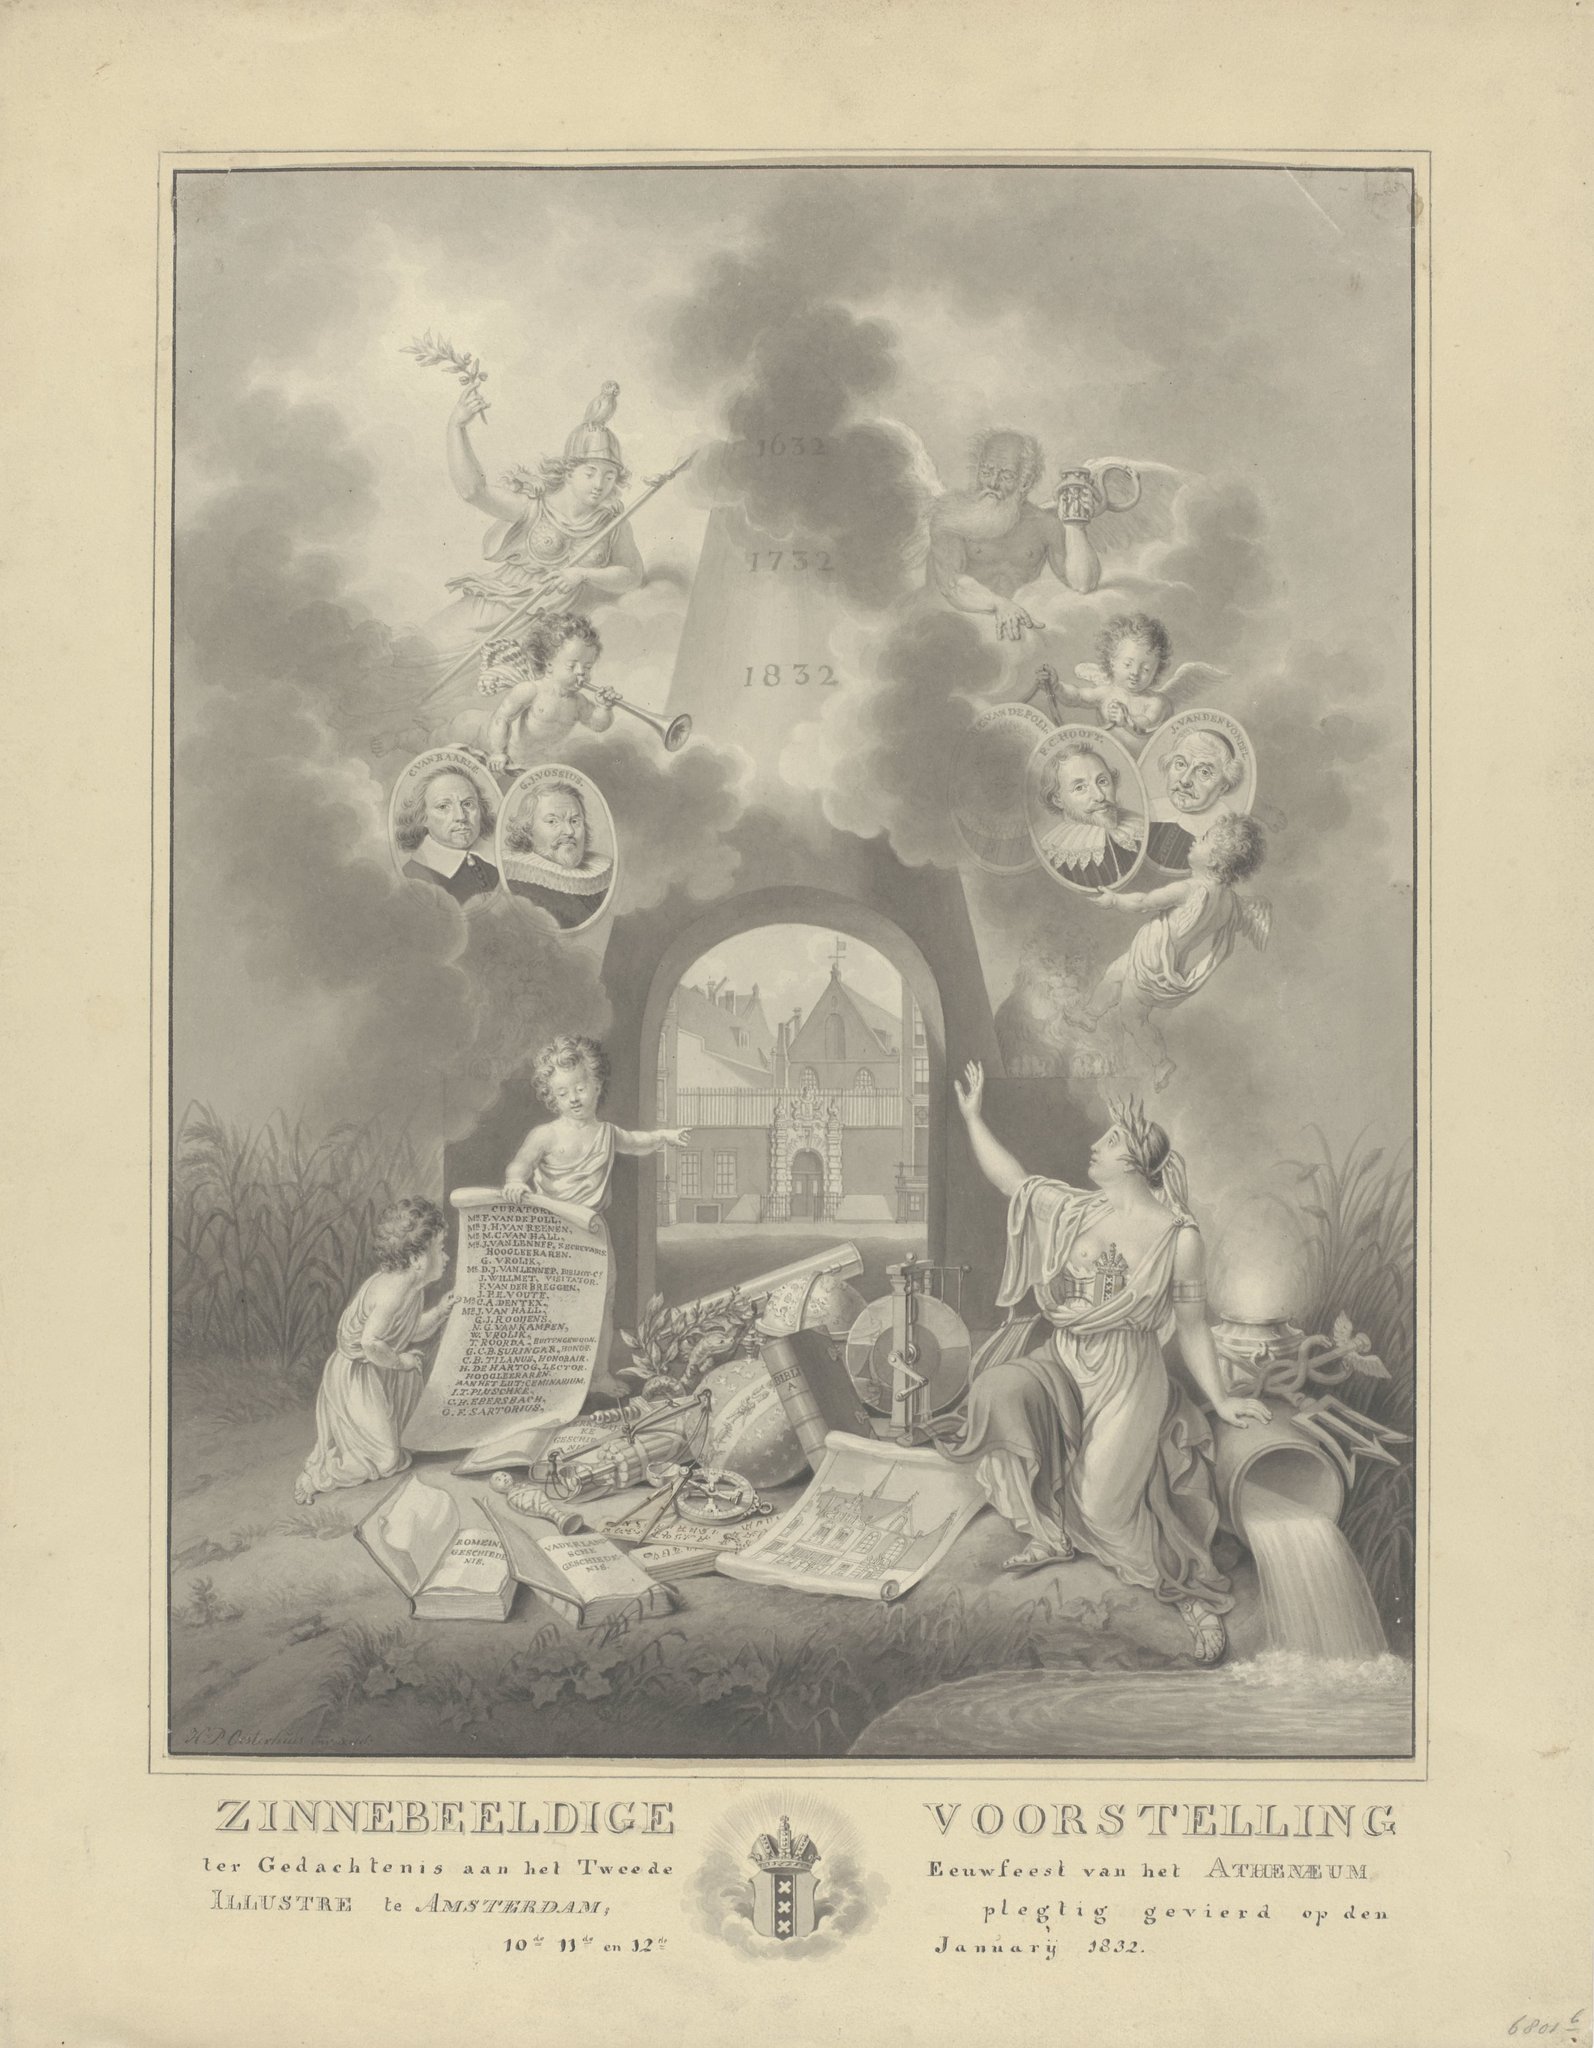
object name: drawing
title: Allegorie op het tweede eeuwfeest van het Athenaeum Illustre te Amsterdam, 1832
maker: dirk sluyter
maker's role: print maker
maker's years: 1790-1852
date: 1832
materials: paper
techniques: brush, pen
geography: amsterdam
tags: antwerp, amsterdam, caspar van baerle, gerardus joannes vossius, pieter corneliszoon hooft, cologne, joost van den vondel, personification of a city, town-patron(ess), father time, man with wings and scythe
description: Allegorie op het tweede eeuwfeest (1632-1832) van het Athenaeum Illustre te Amsterdam, gevierd 10-12 januari 1832. Naald met opening waardoor een gezicht op de poort naar de Agnietenkapel aan de Oudezijds Voorburgwal te Amsterdam waar Athenaeum Illustre is gevestigd. Rechts de stedenmaagd van Amsterdam, links twee geniussen met een lijst van de namen van de curatoren en professoren. Op de grond boeken en wetenschappelijke instrumenten. In de wolken Minerva en Vader Tijd met medaillons met portretten van Caspar van Baerle, H.G. van de Poll, Vossius, P.C. Hooft en Joost van den Vondel.